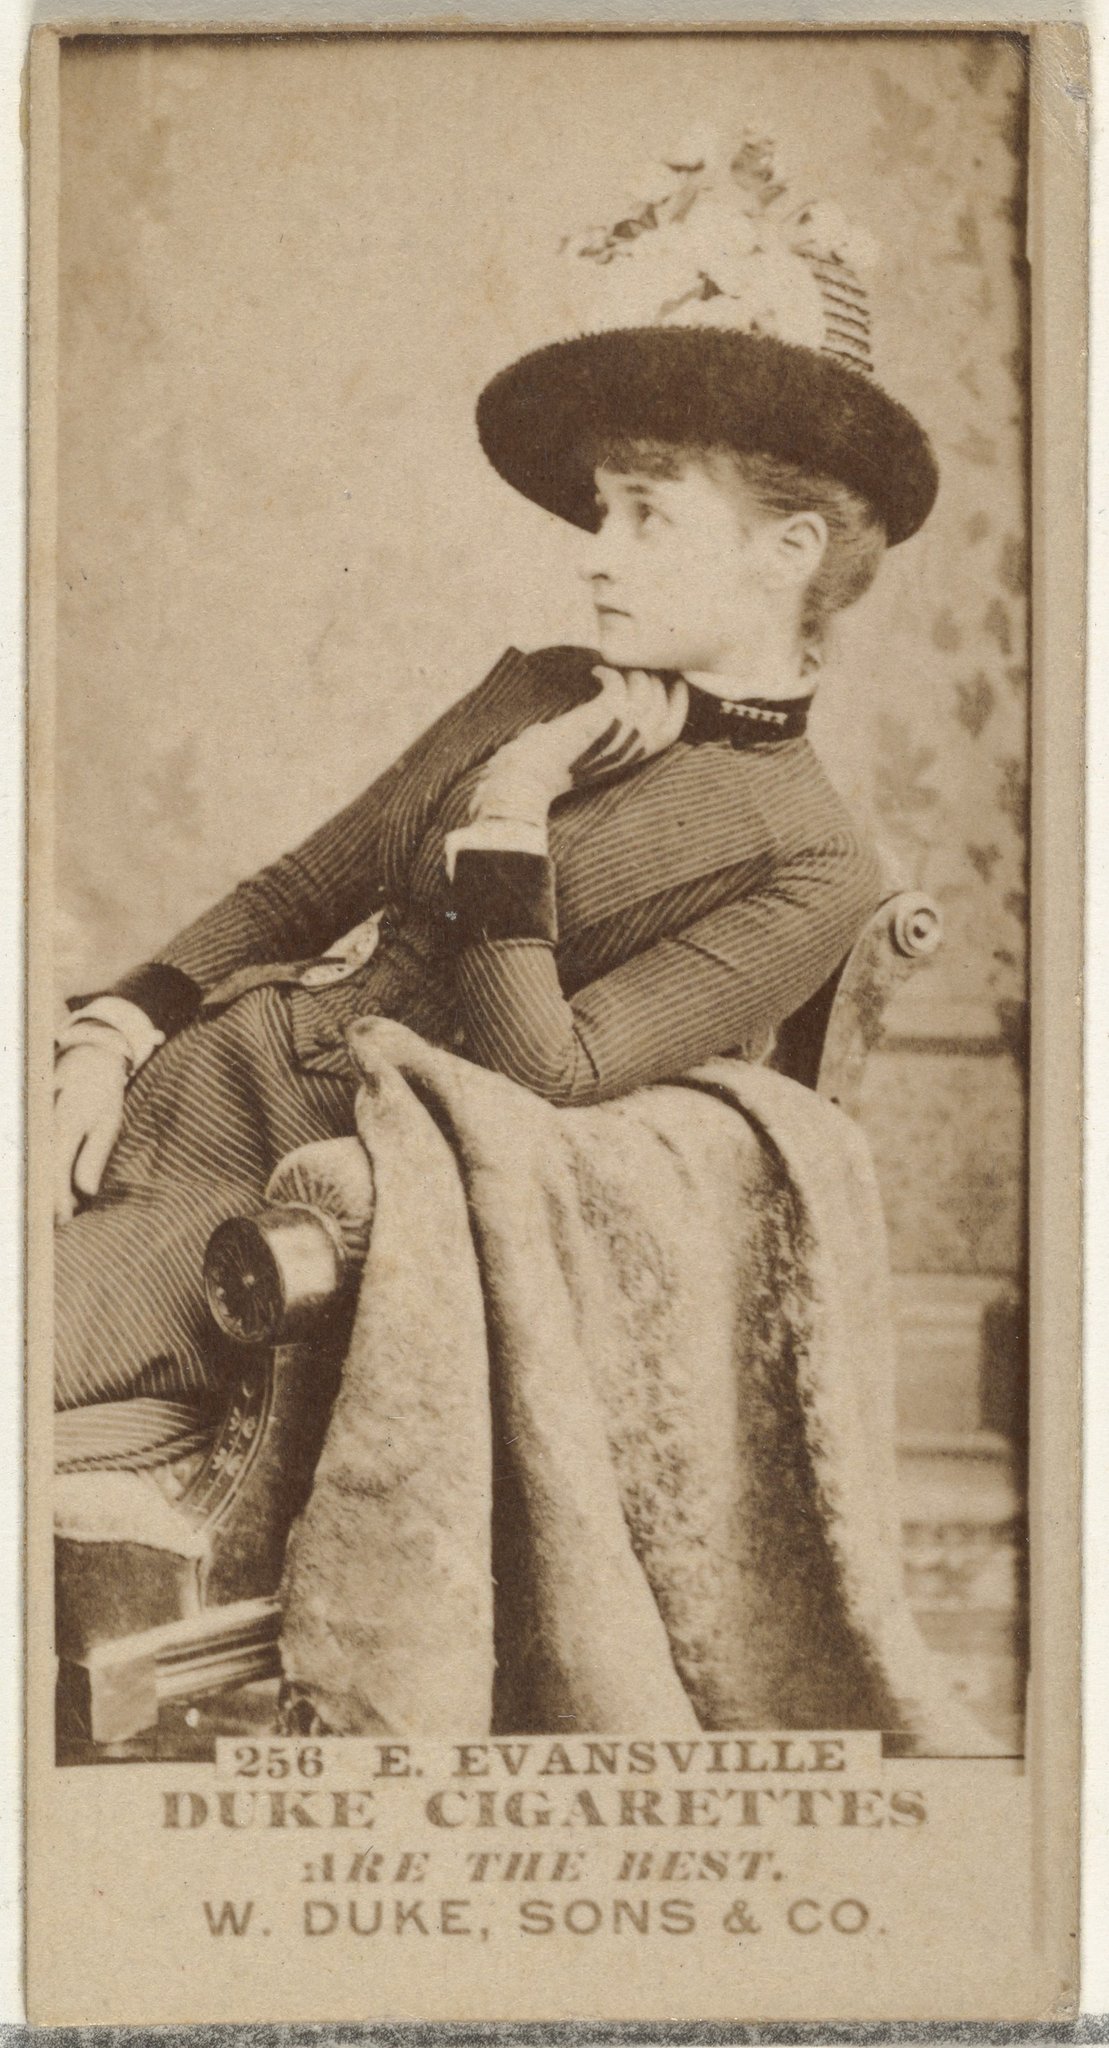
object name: photograph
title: Card Number 256, E. Evansville, from the Actors and Actresses series (N145-7) issued by Duke Sons & Co. to promote Duke Cigarettes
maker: w. duke, sons & co.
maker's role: publisher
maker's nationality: american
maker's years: 1870-1920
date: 1880-1889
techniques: albumen silver print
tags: portraits,women,actresses